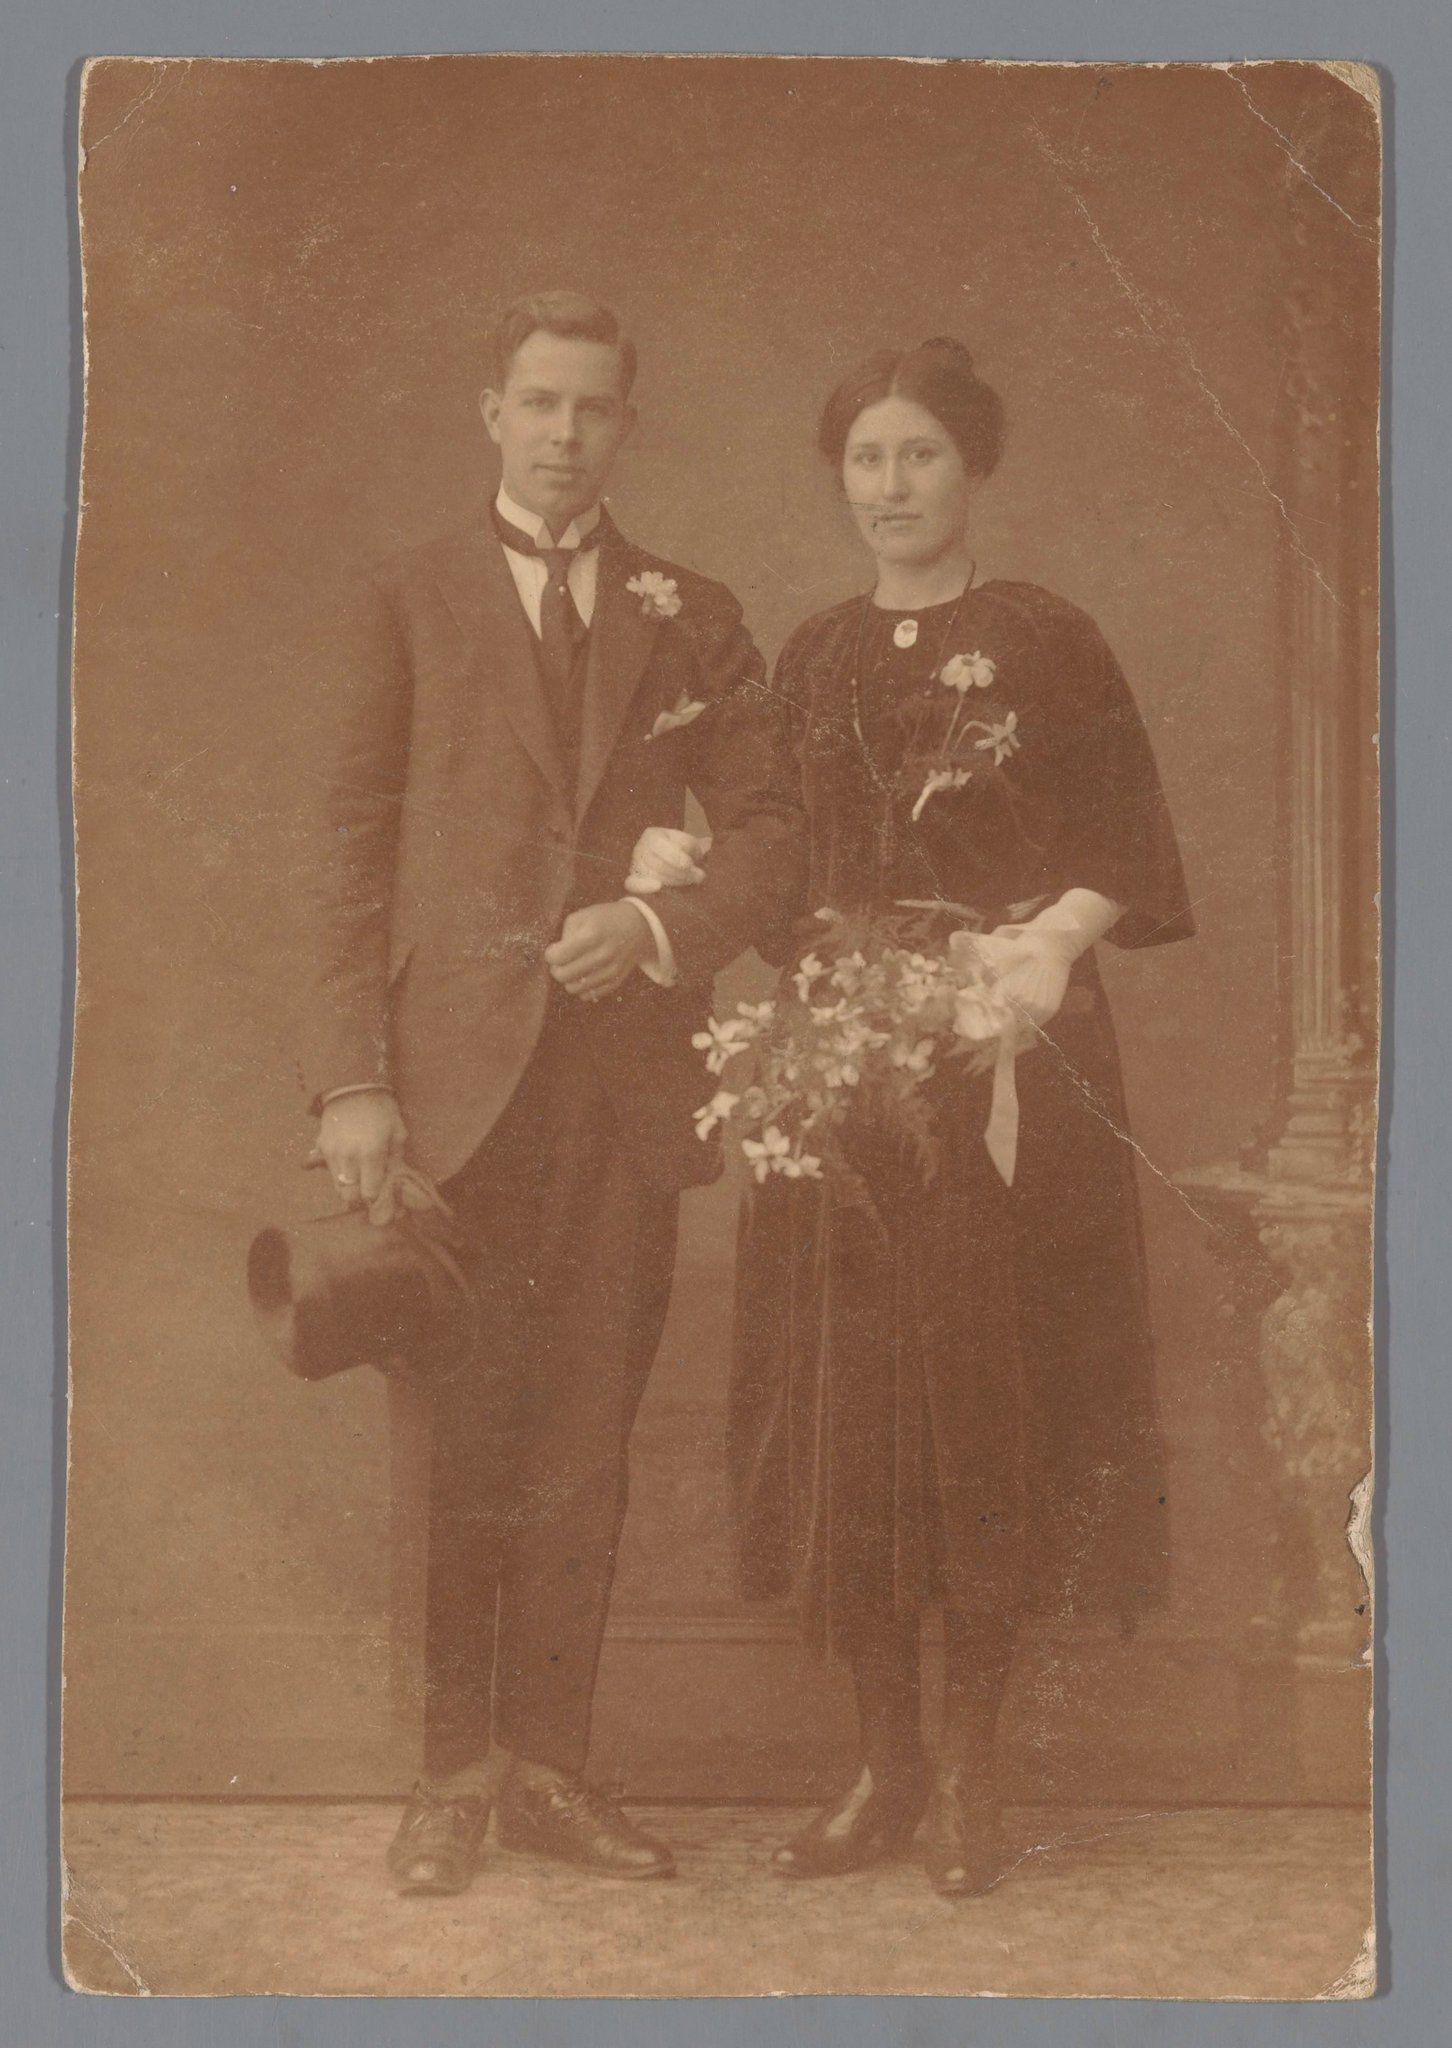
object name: photograph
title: Portret van een onbekend bruidspaar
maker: Anonymous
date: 1880-1915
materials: cardboard, photographic support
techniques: daylight paper print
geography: netherlands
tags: studio requisites ~ photographer, bride and groom in wedding-dress